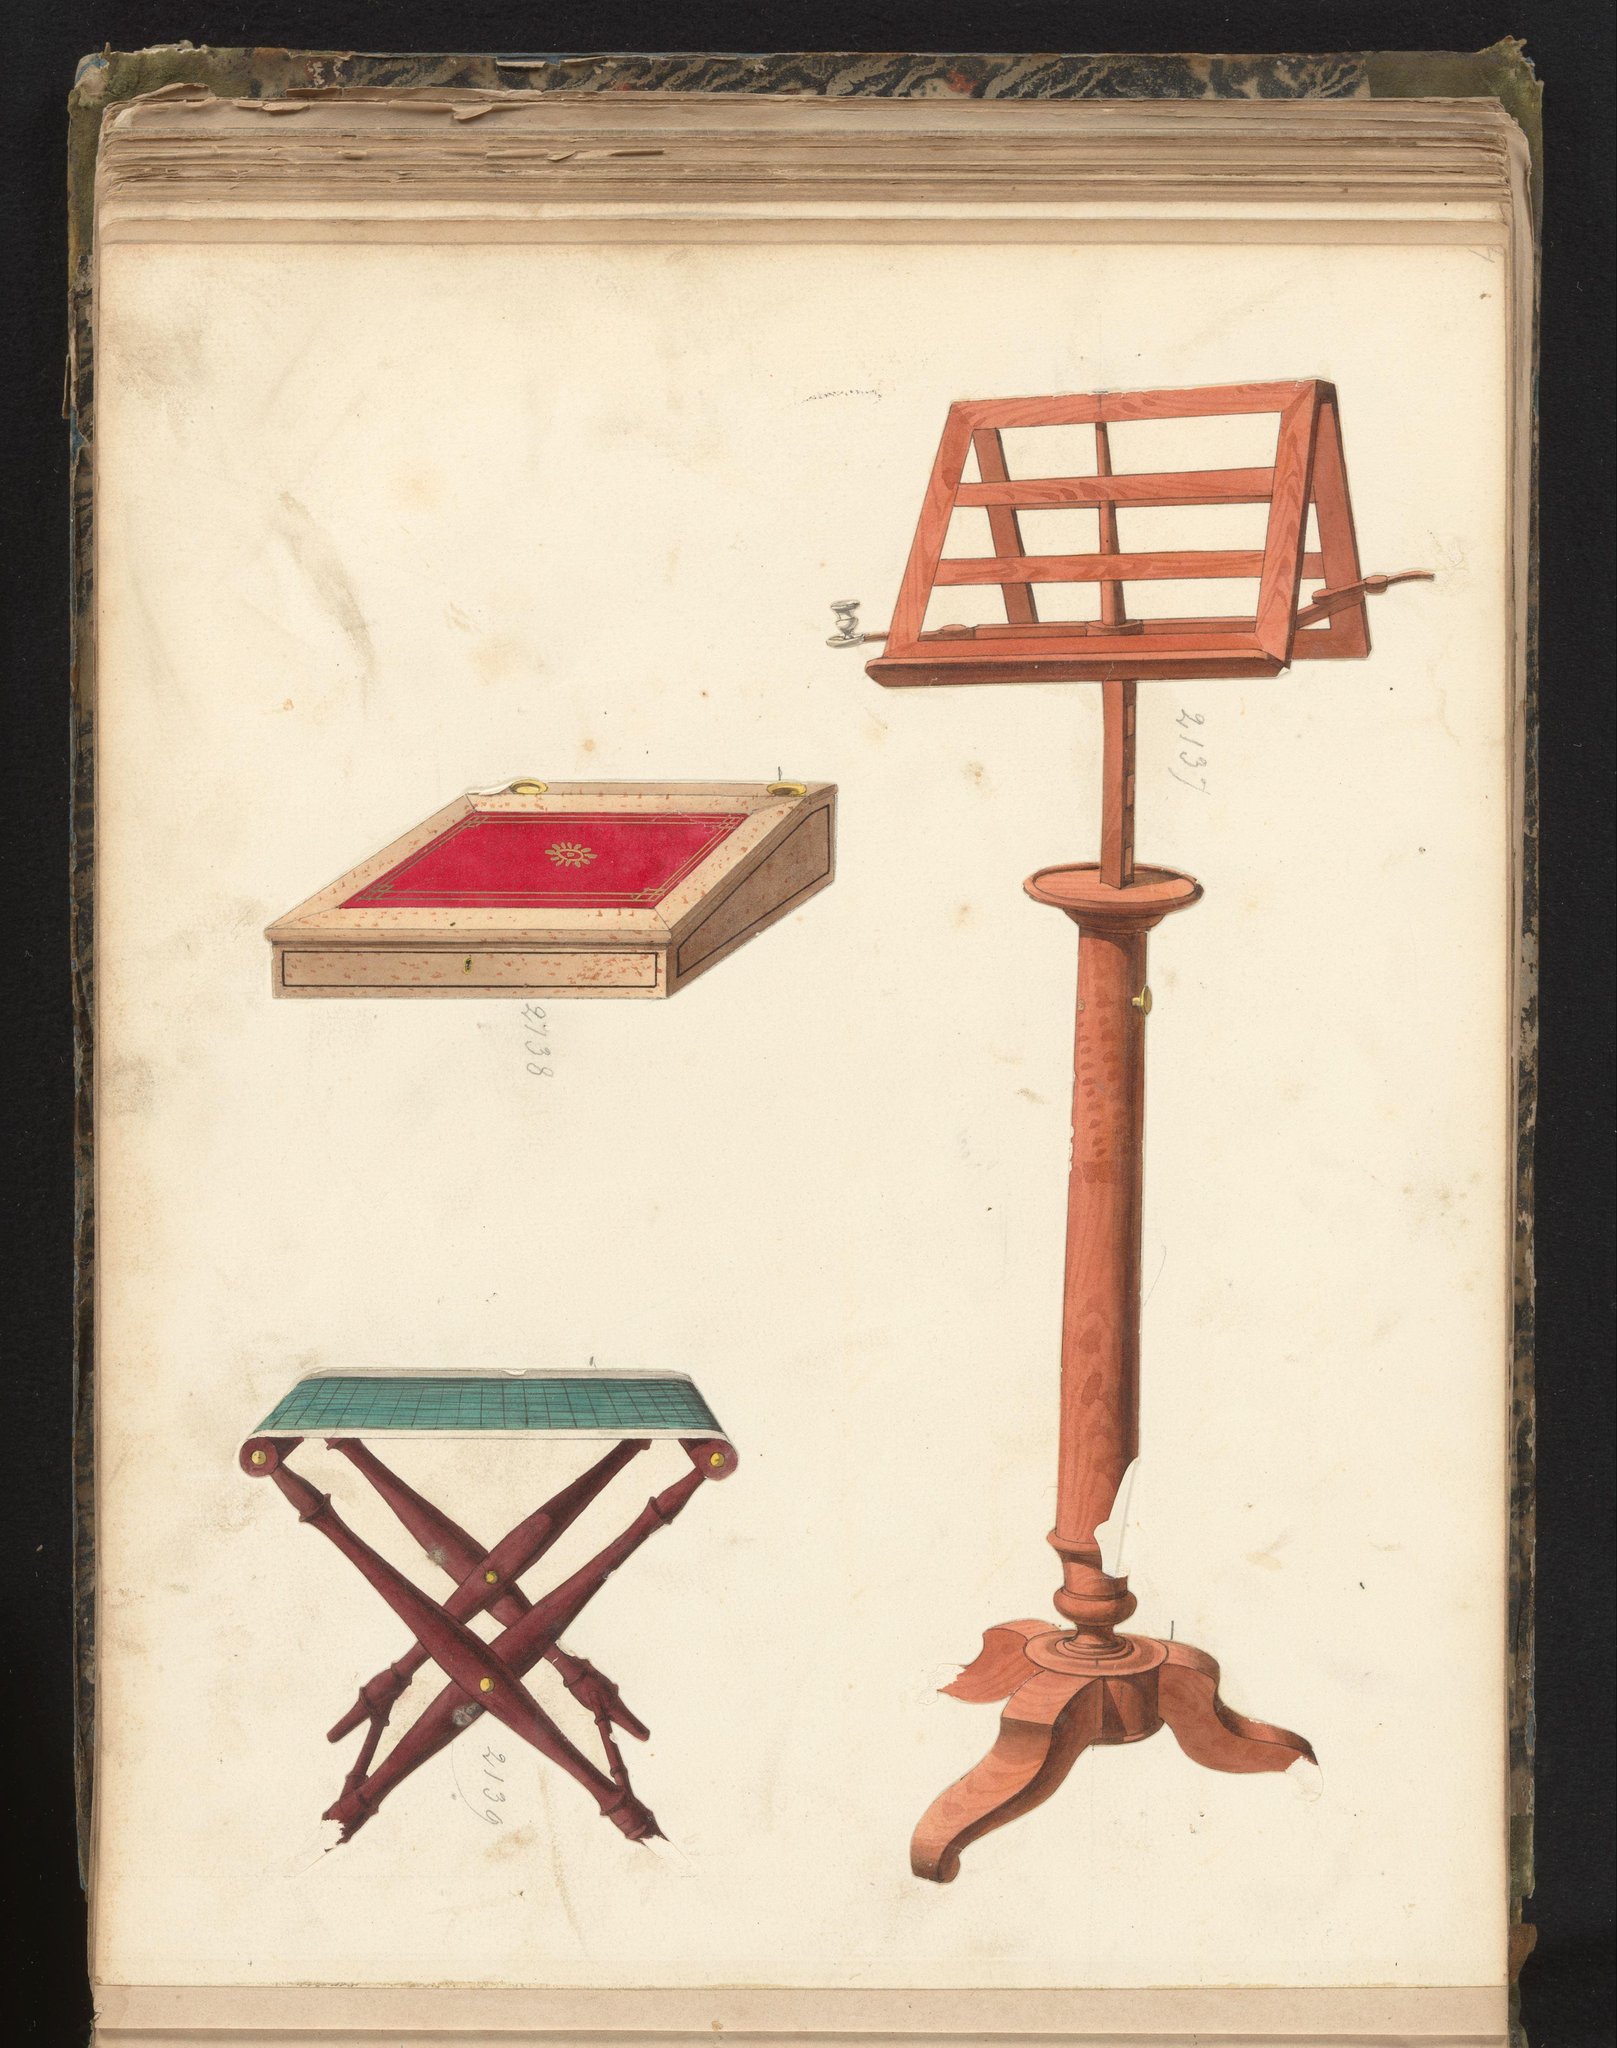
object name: drawing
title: Drie ontwerpen, een muzieklessenaar, een vouwstoel en een lessenaar met inktstel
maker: Anonymous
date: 1825-1839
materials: ink, paper, pencil, watercolor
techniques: brush, pen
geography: paris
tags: furniture for special use (+ wood and other phytogenic material), stool, accessories ~ music: metronome, music-stand, tuning-fork, etc., lectern ~ reading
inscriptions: inscription: ‘2137 Porte Musique en acajou avase ‘’…’’ merisier au noyer 2139 Chaise pliantes garnis tisses 12 14 16 18 20 22 pouces Chaises pliantes fauteuils 2138 Pupitres de bureau en bois diverze 12 14 16 18 20 pouces’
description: Drie ontwerpen waarvan een van een muzieklessenaar (mahoniehout), een ontwerp voor een vouwstoel en een ontwerp voor een lessenaar met inkt-stel (verscheidene houtsoorten). Het blad op de achterzijde genummerd: 36, het tegenoverliggende blad met informatie over de afgebeelde meubelen genummerd: 36 bis. Onderdeel van een album met 80 bladen met tekeningen en een prent van gefineerde en gelakte meubelen, alsmede zitmeubelen.